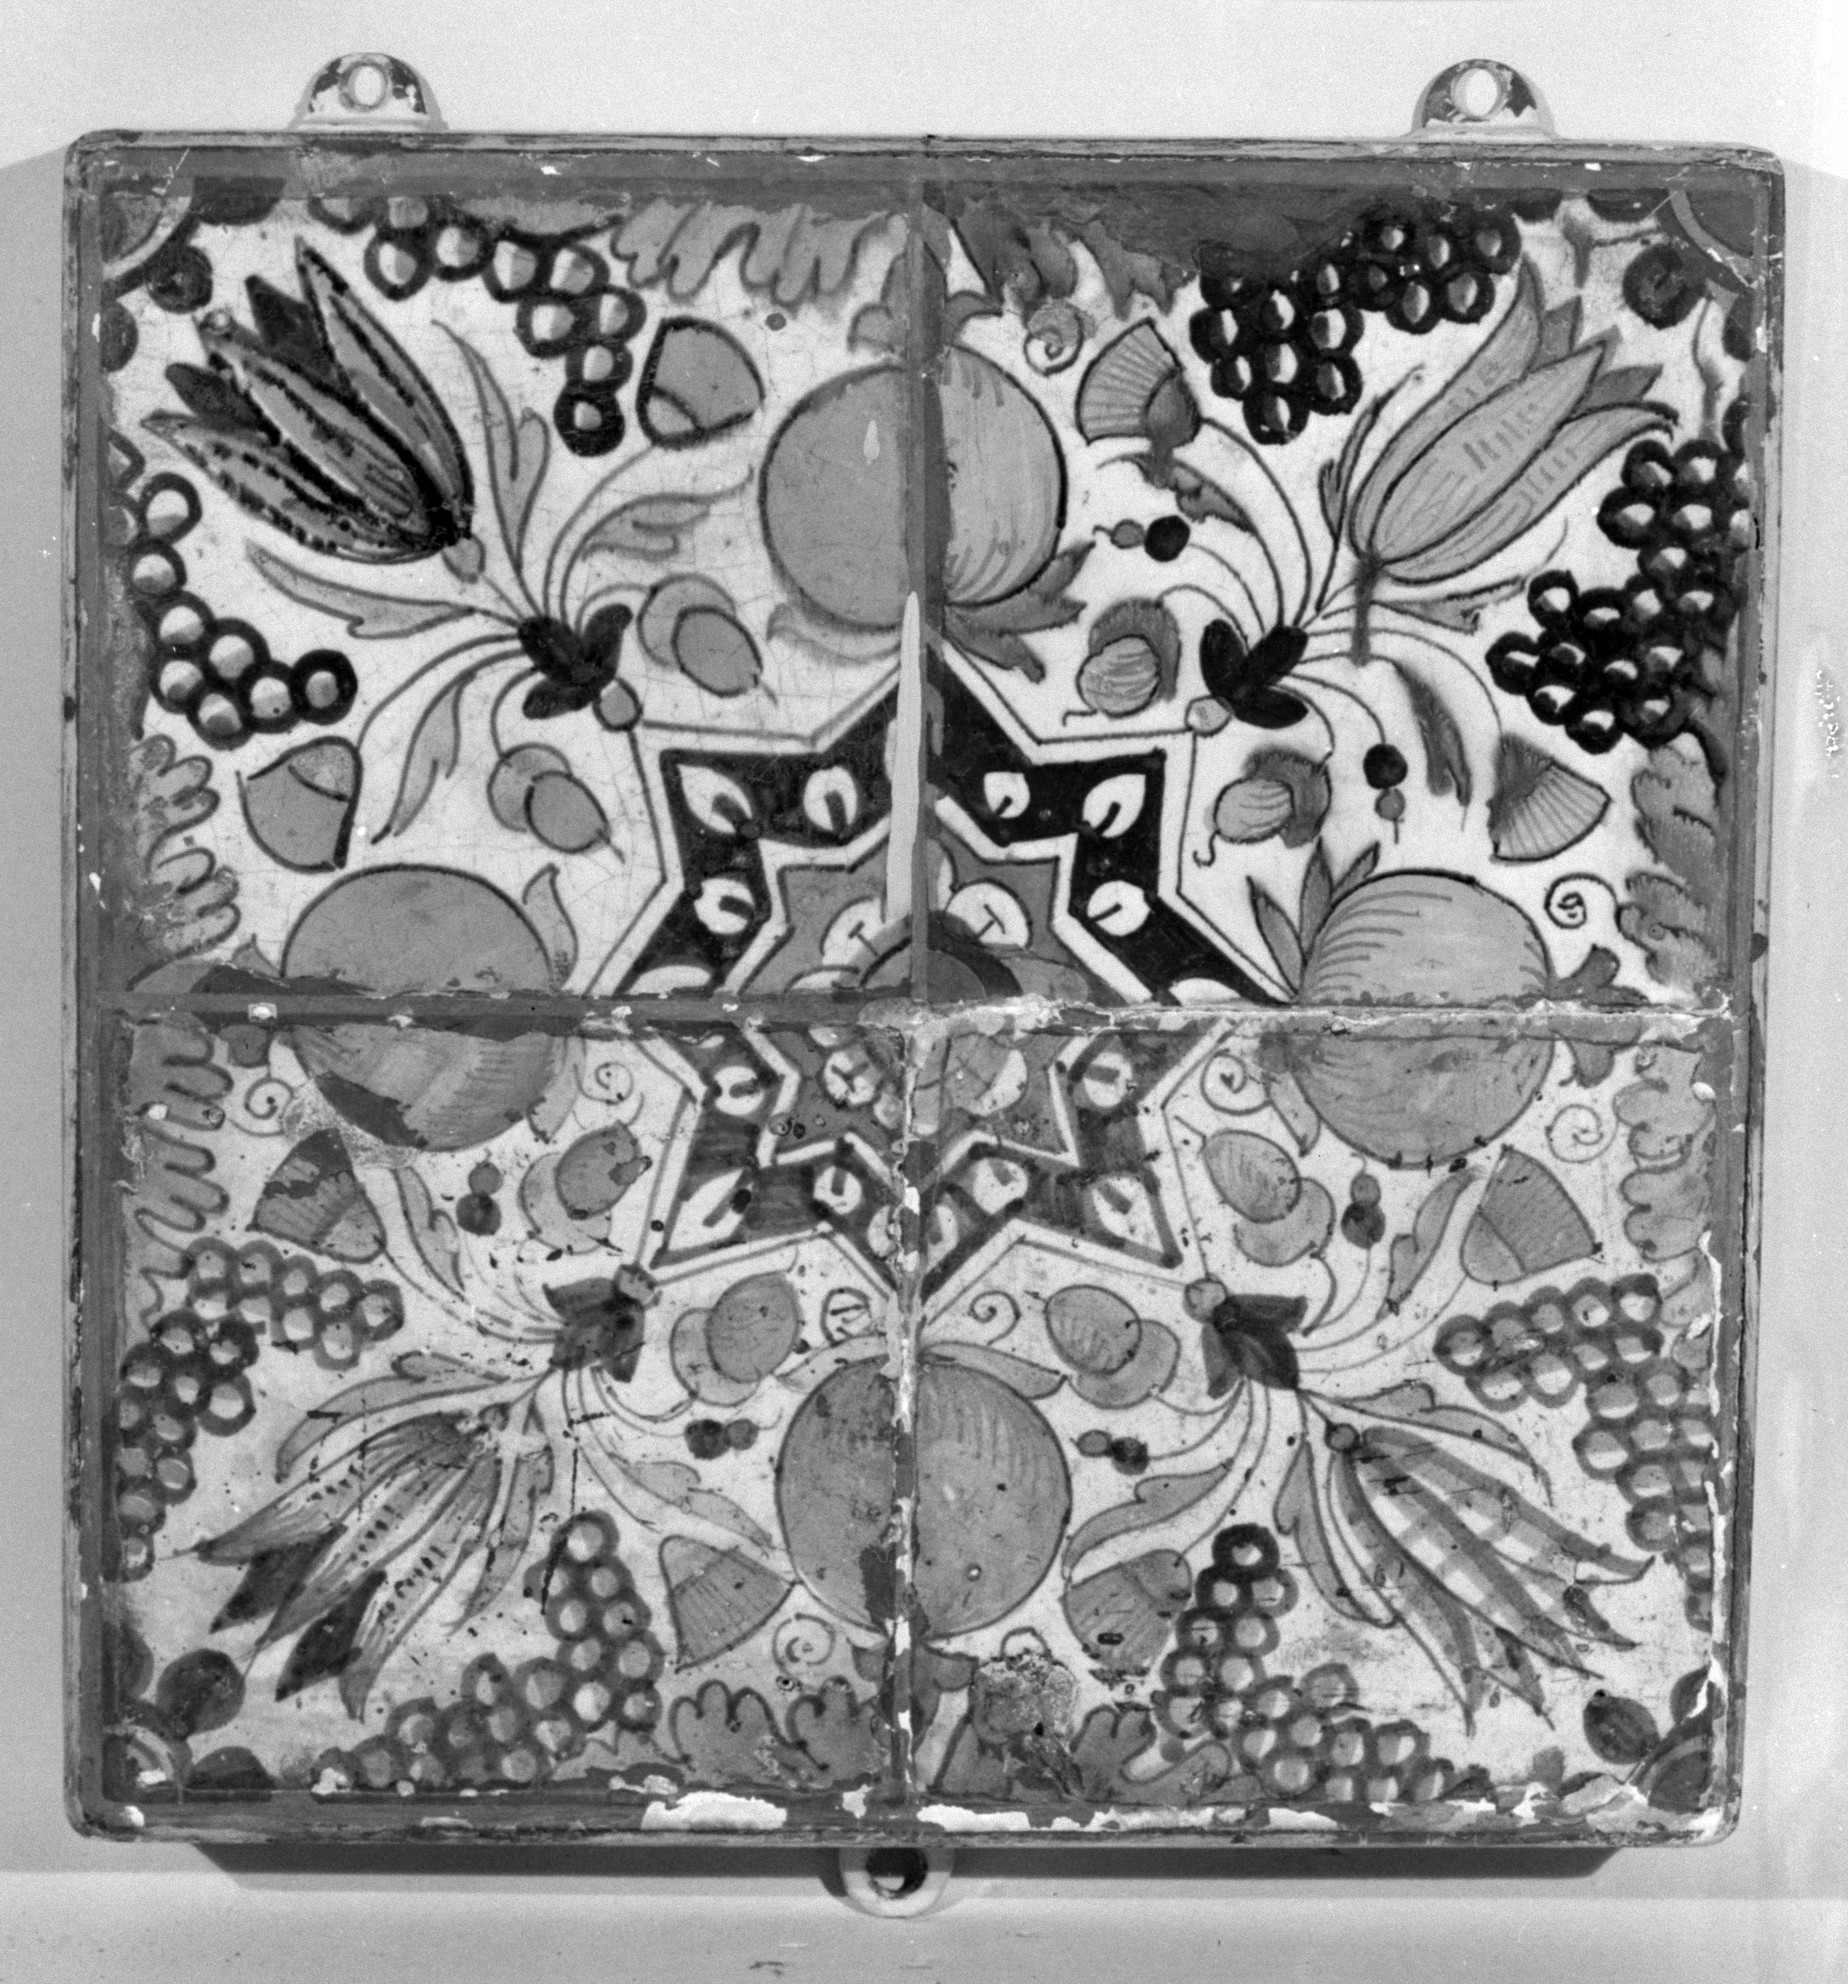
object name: tile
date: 1601-1625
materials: earthenware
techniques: glazing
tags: lotuses